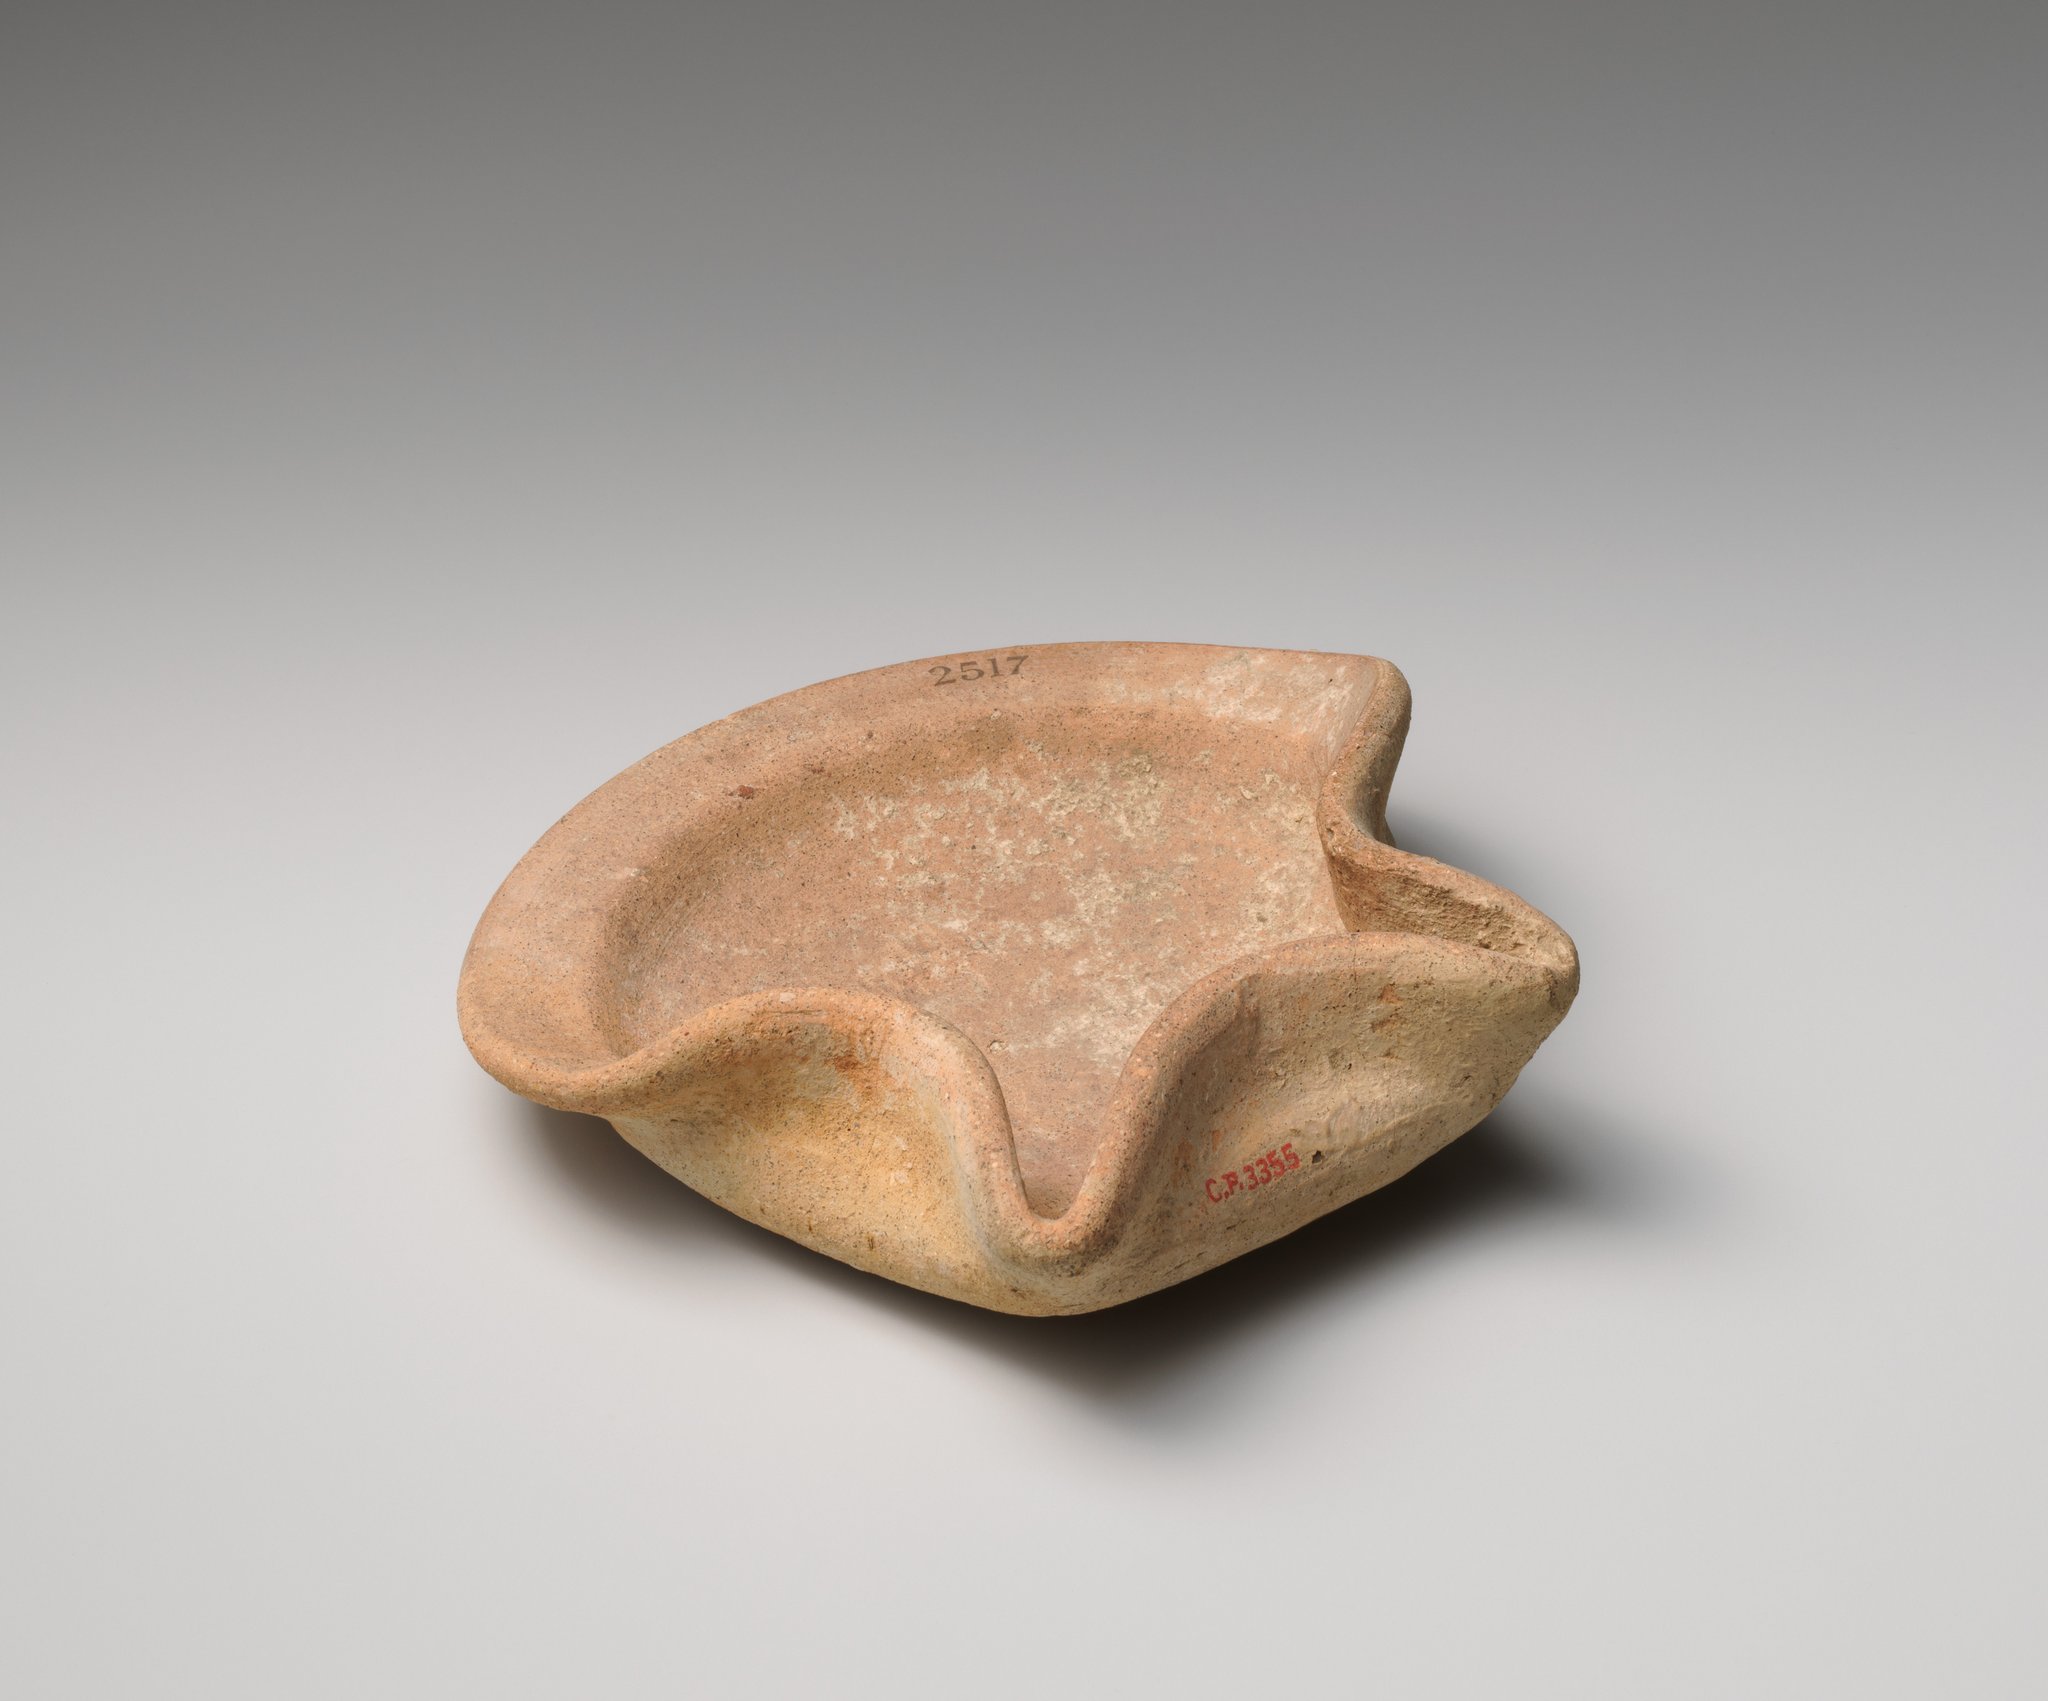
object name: lamp, saucer shaped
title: Terracotta saucer-shaped oil lamp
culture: cypriot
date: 400-301 BCE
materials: terracotta